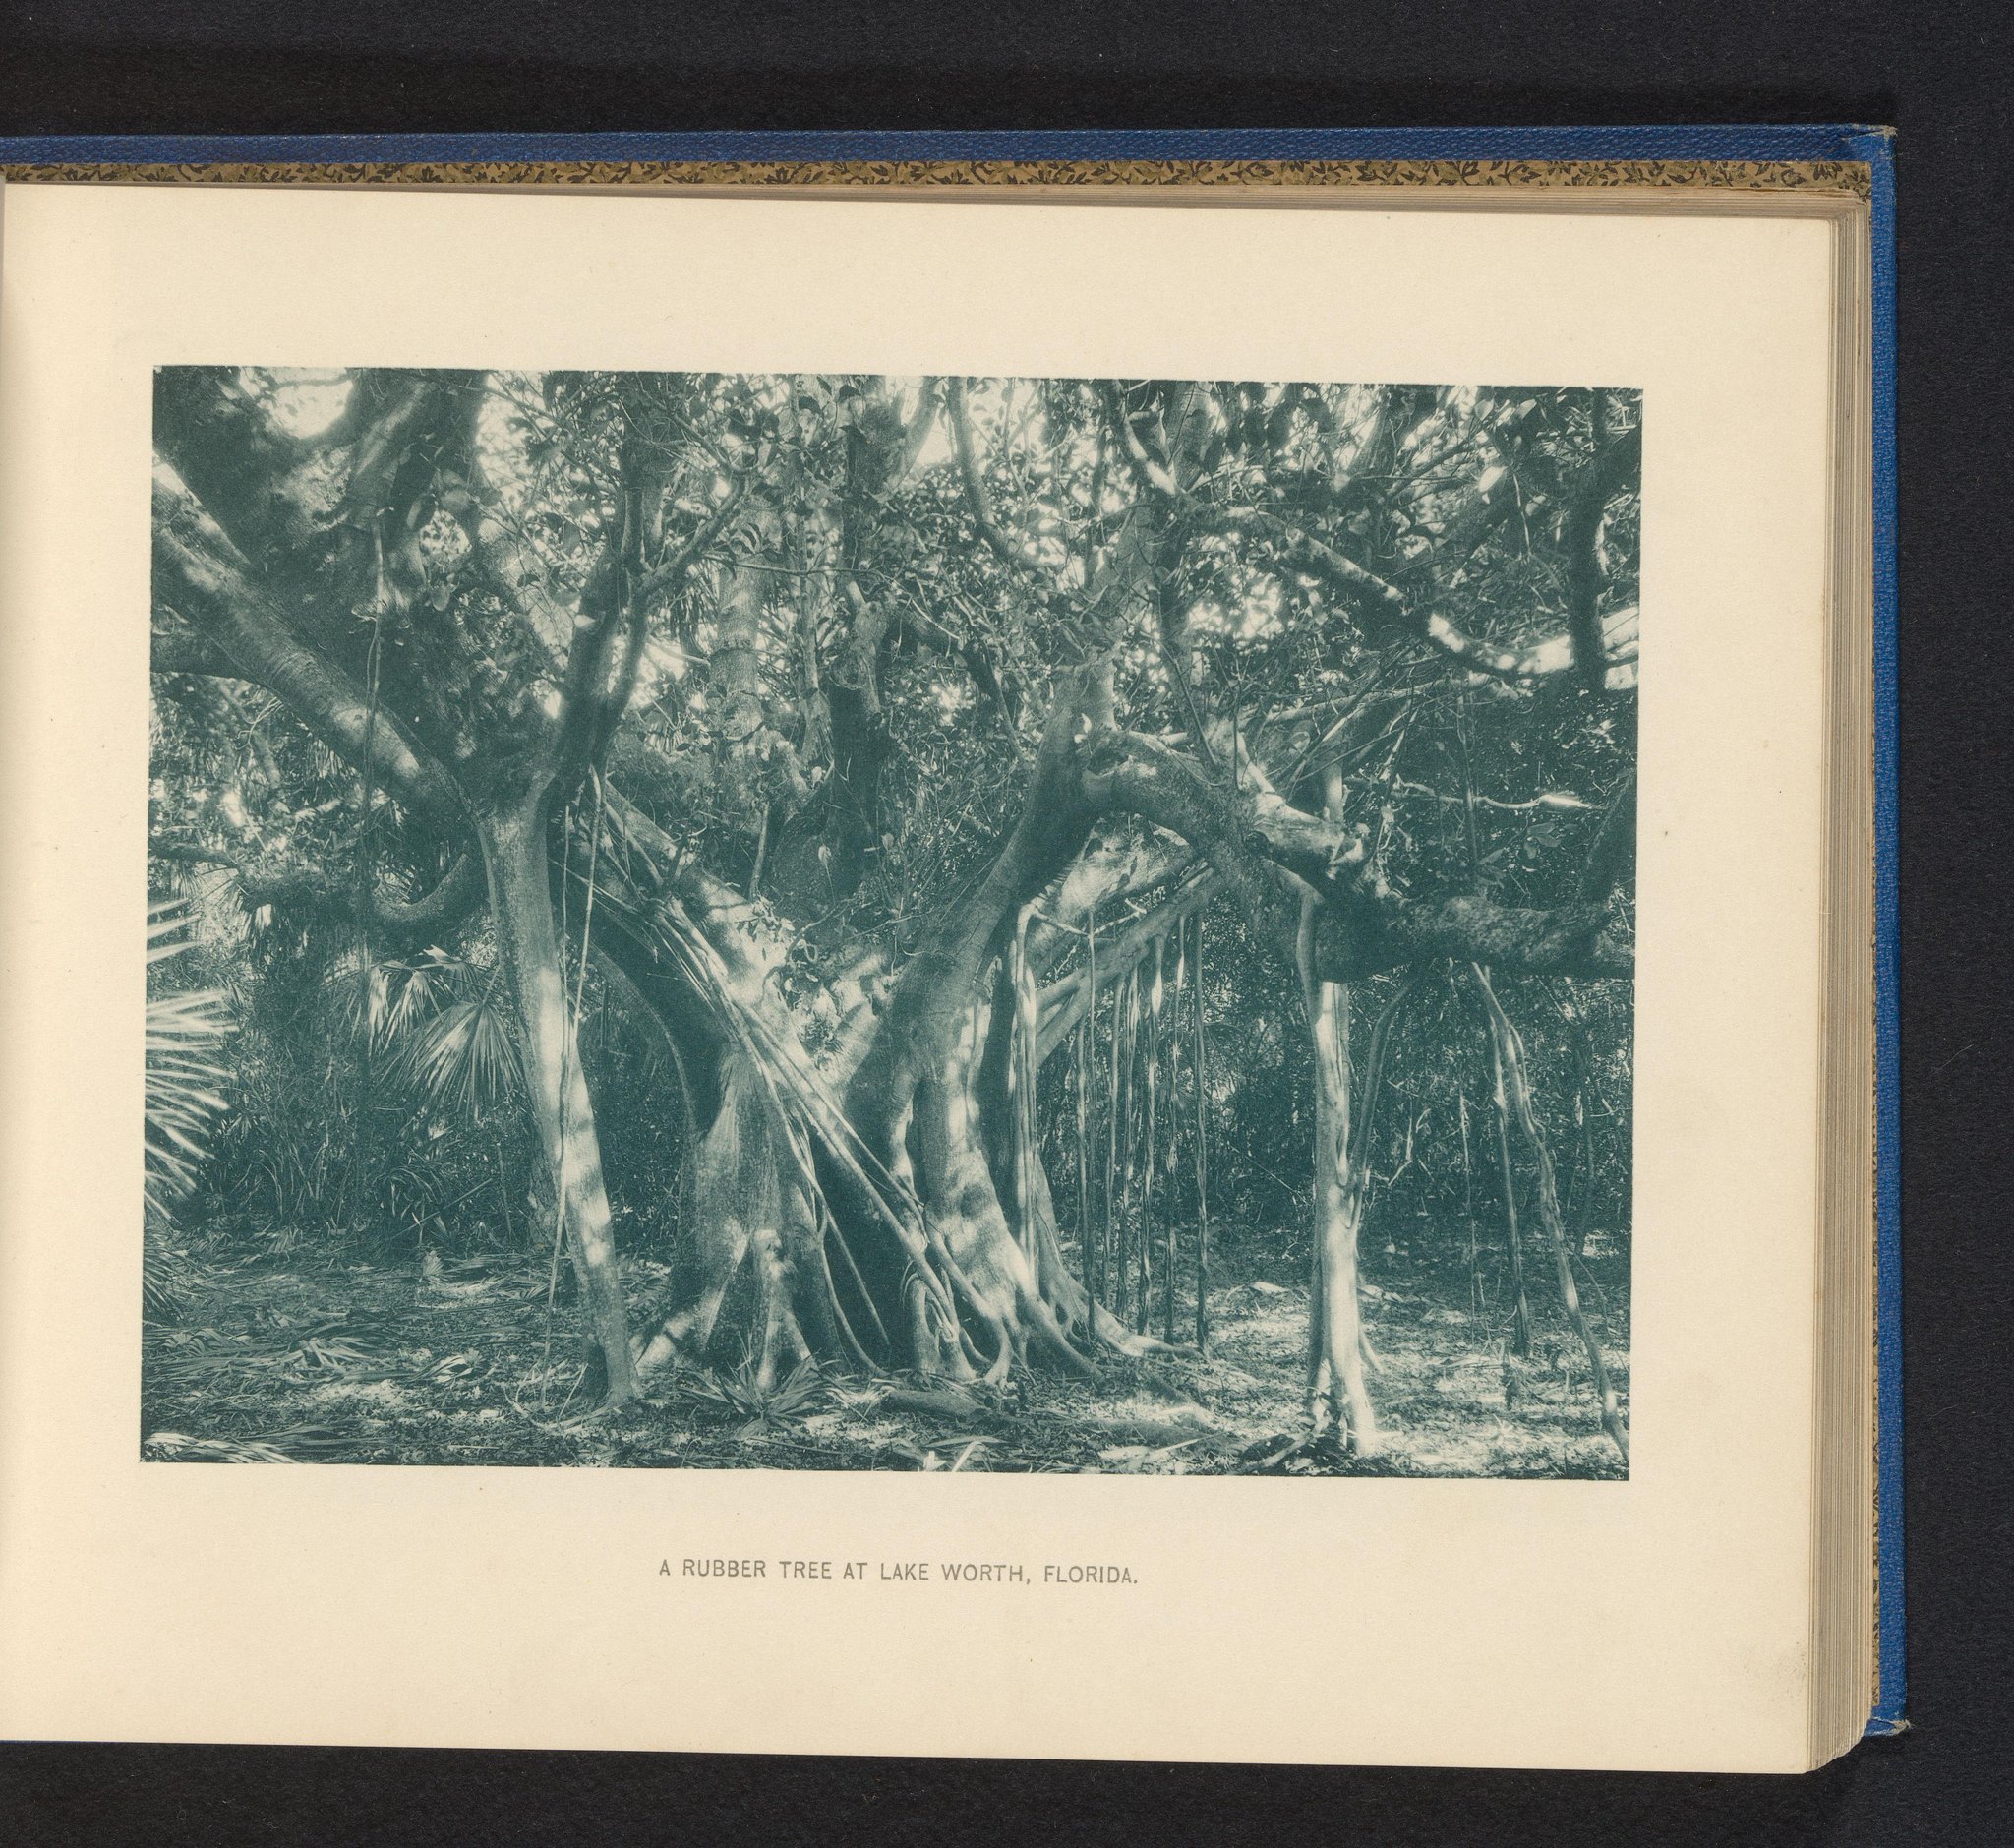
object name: photomechanical print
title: A rubber tree at Lake Worth, Florida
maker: Anonymous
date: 1883-1893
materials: paper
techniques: photograph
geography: lake worth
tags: trees